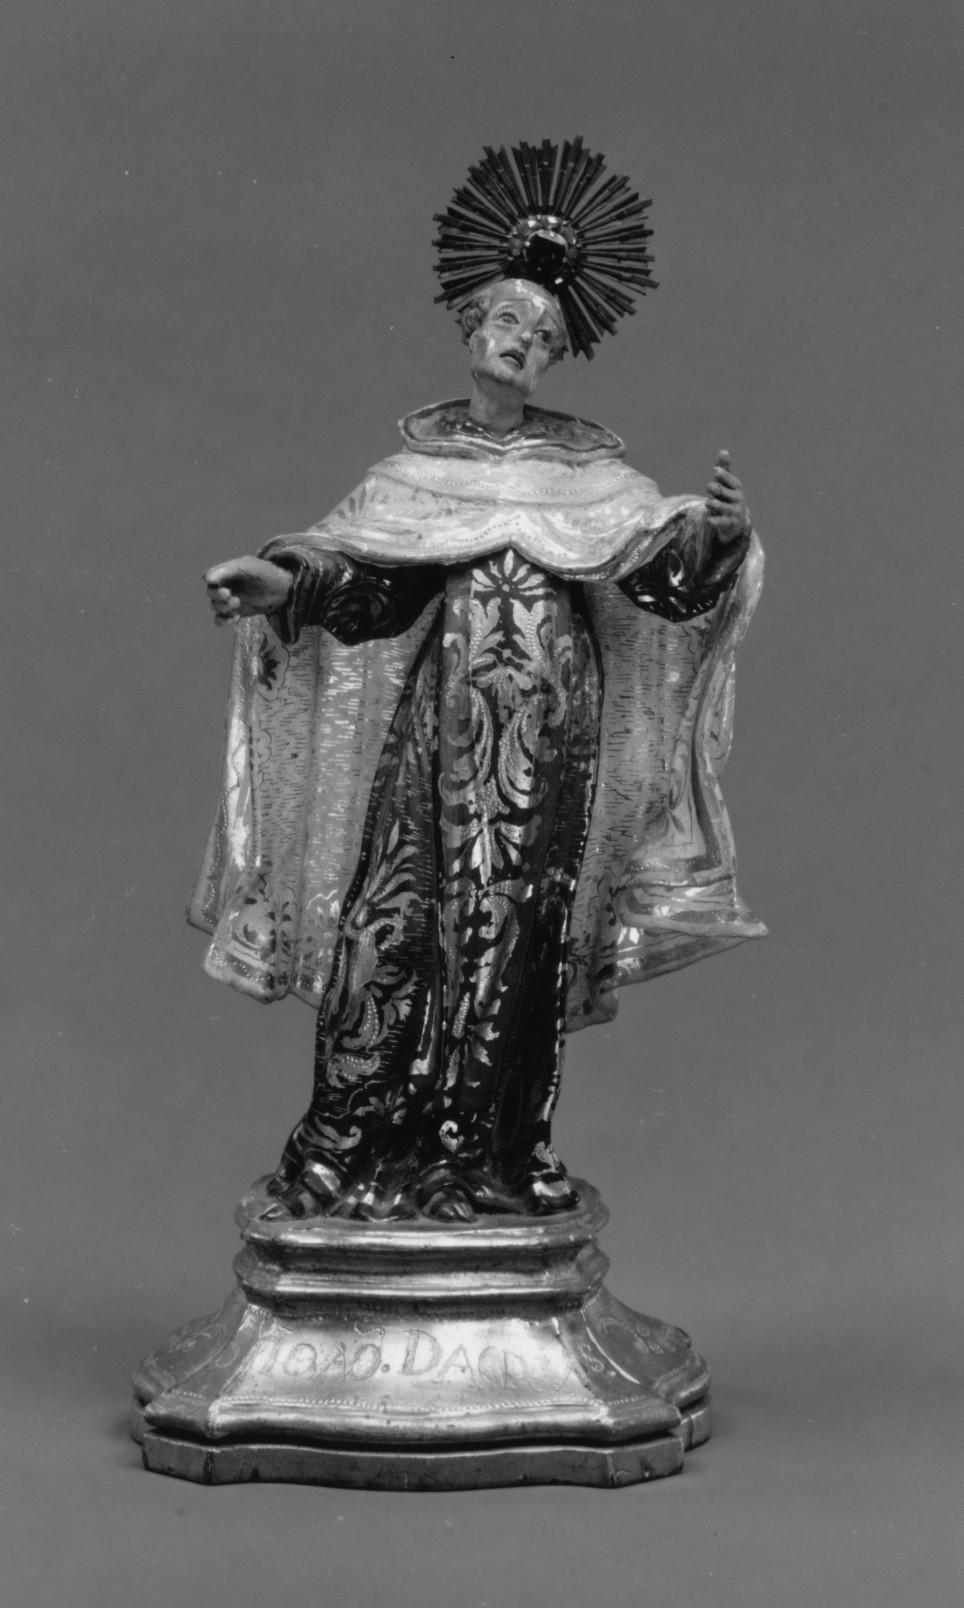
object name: statuette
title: Saint John of the Cross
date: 1701-1800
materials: glass, silver, wood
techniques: gilding, polychrome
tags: saint john the baptist